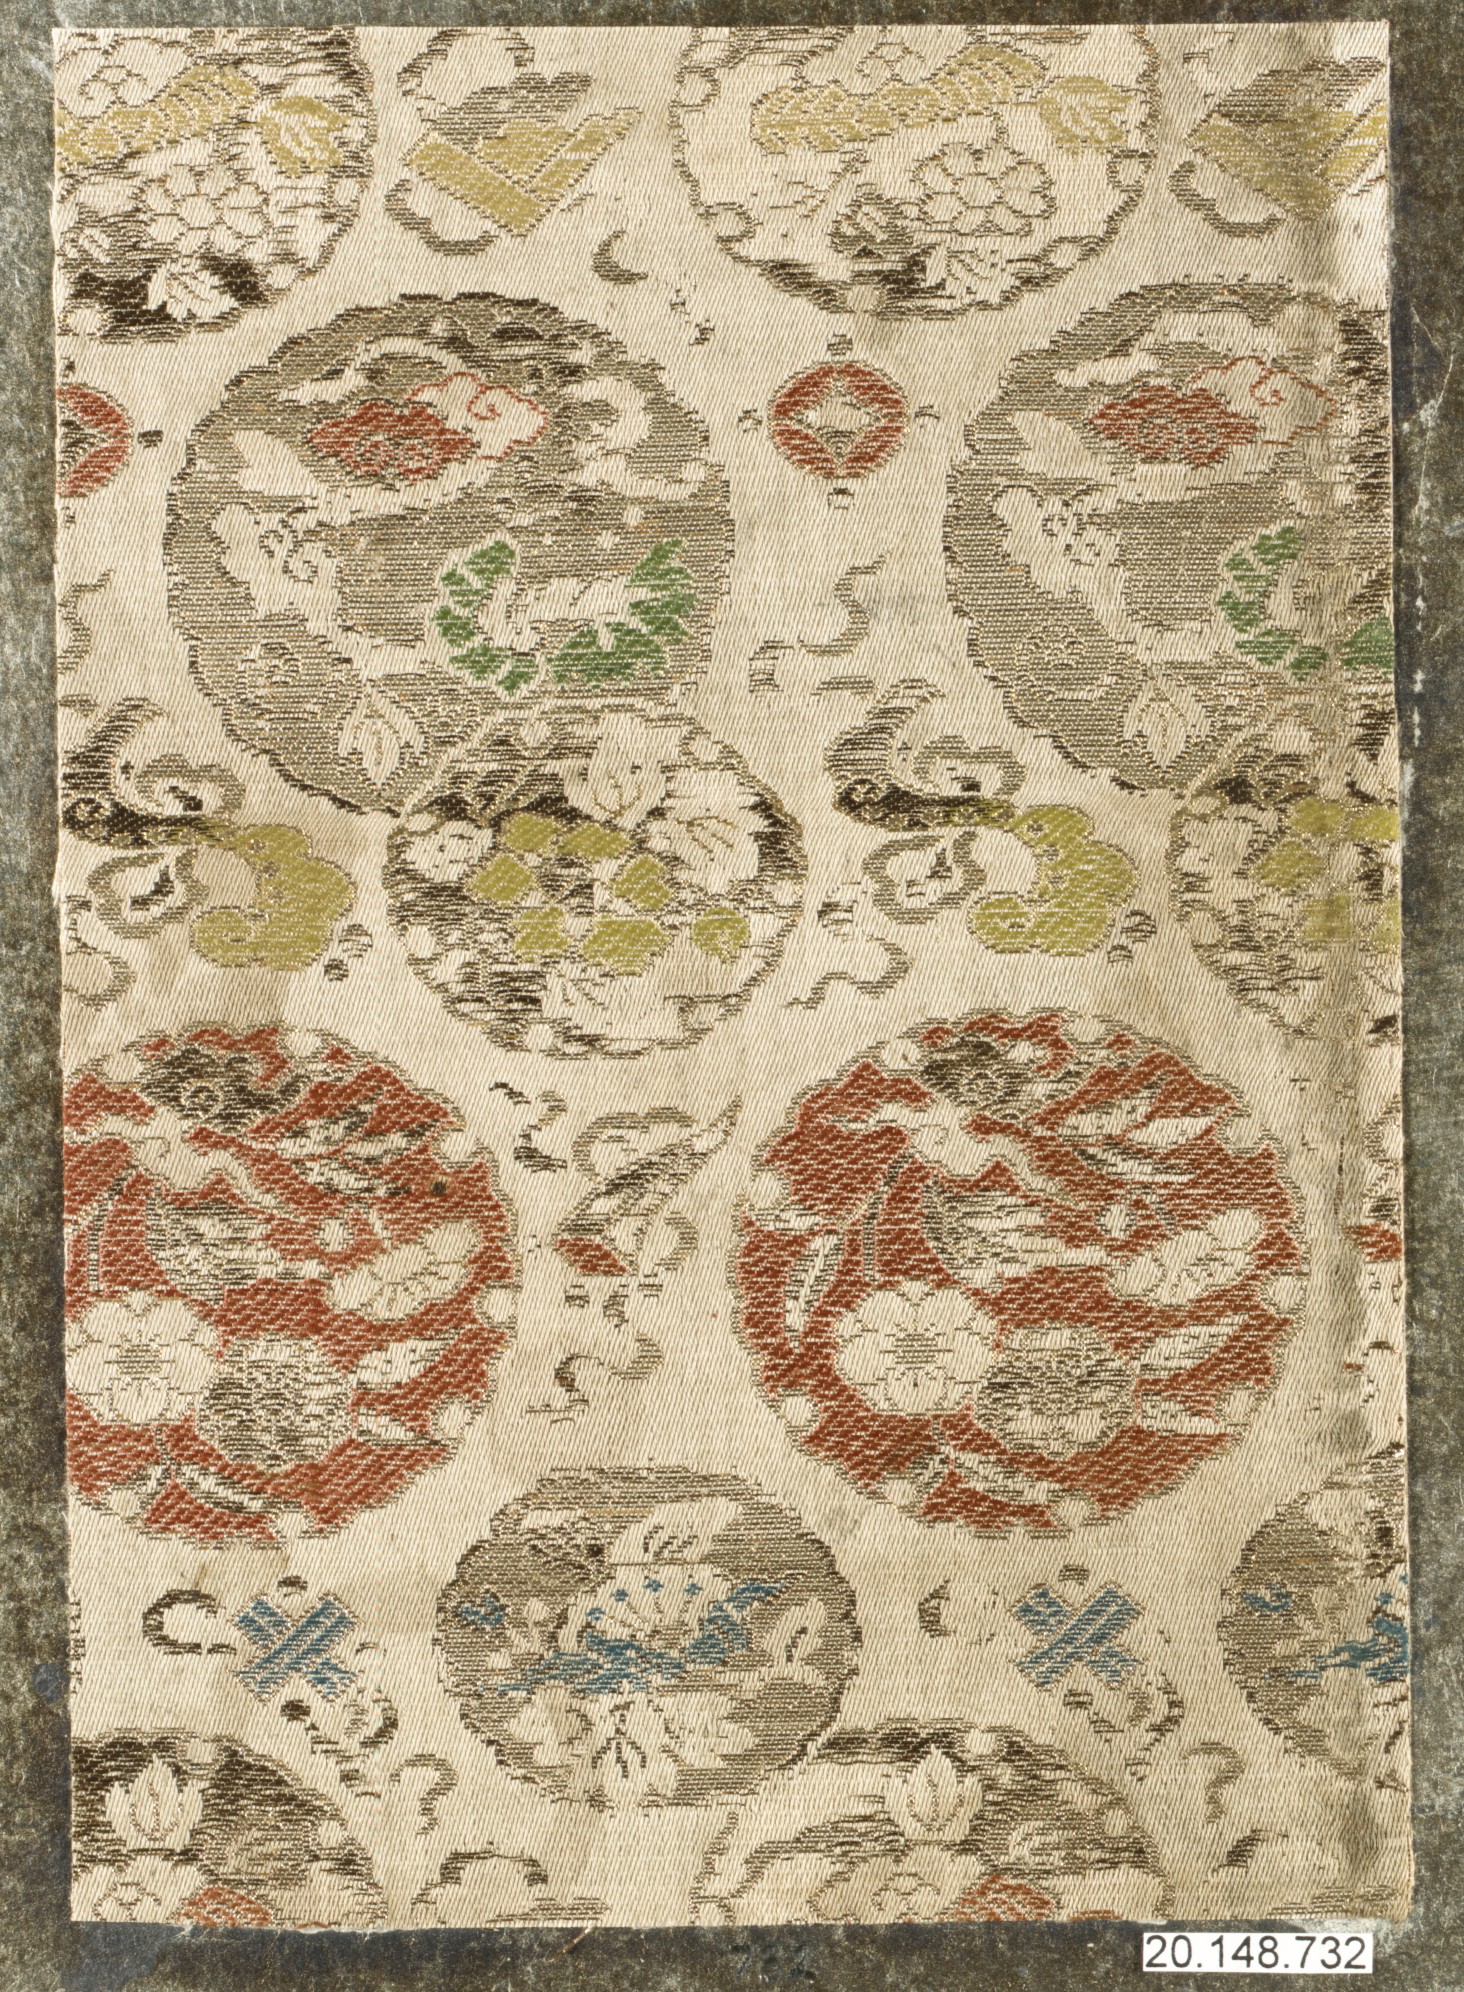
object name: piece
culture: japanese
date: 1701-1800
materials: silk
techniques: compound weave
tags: flowers